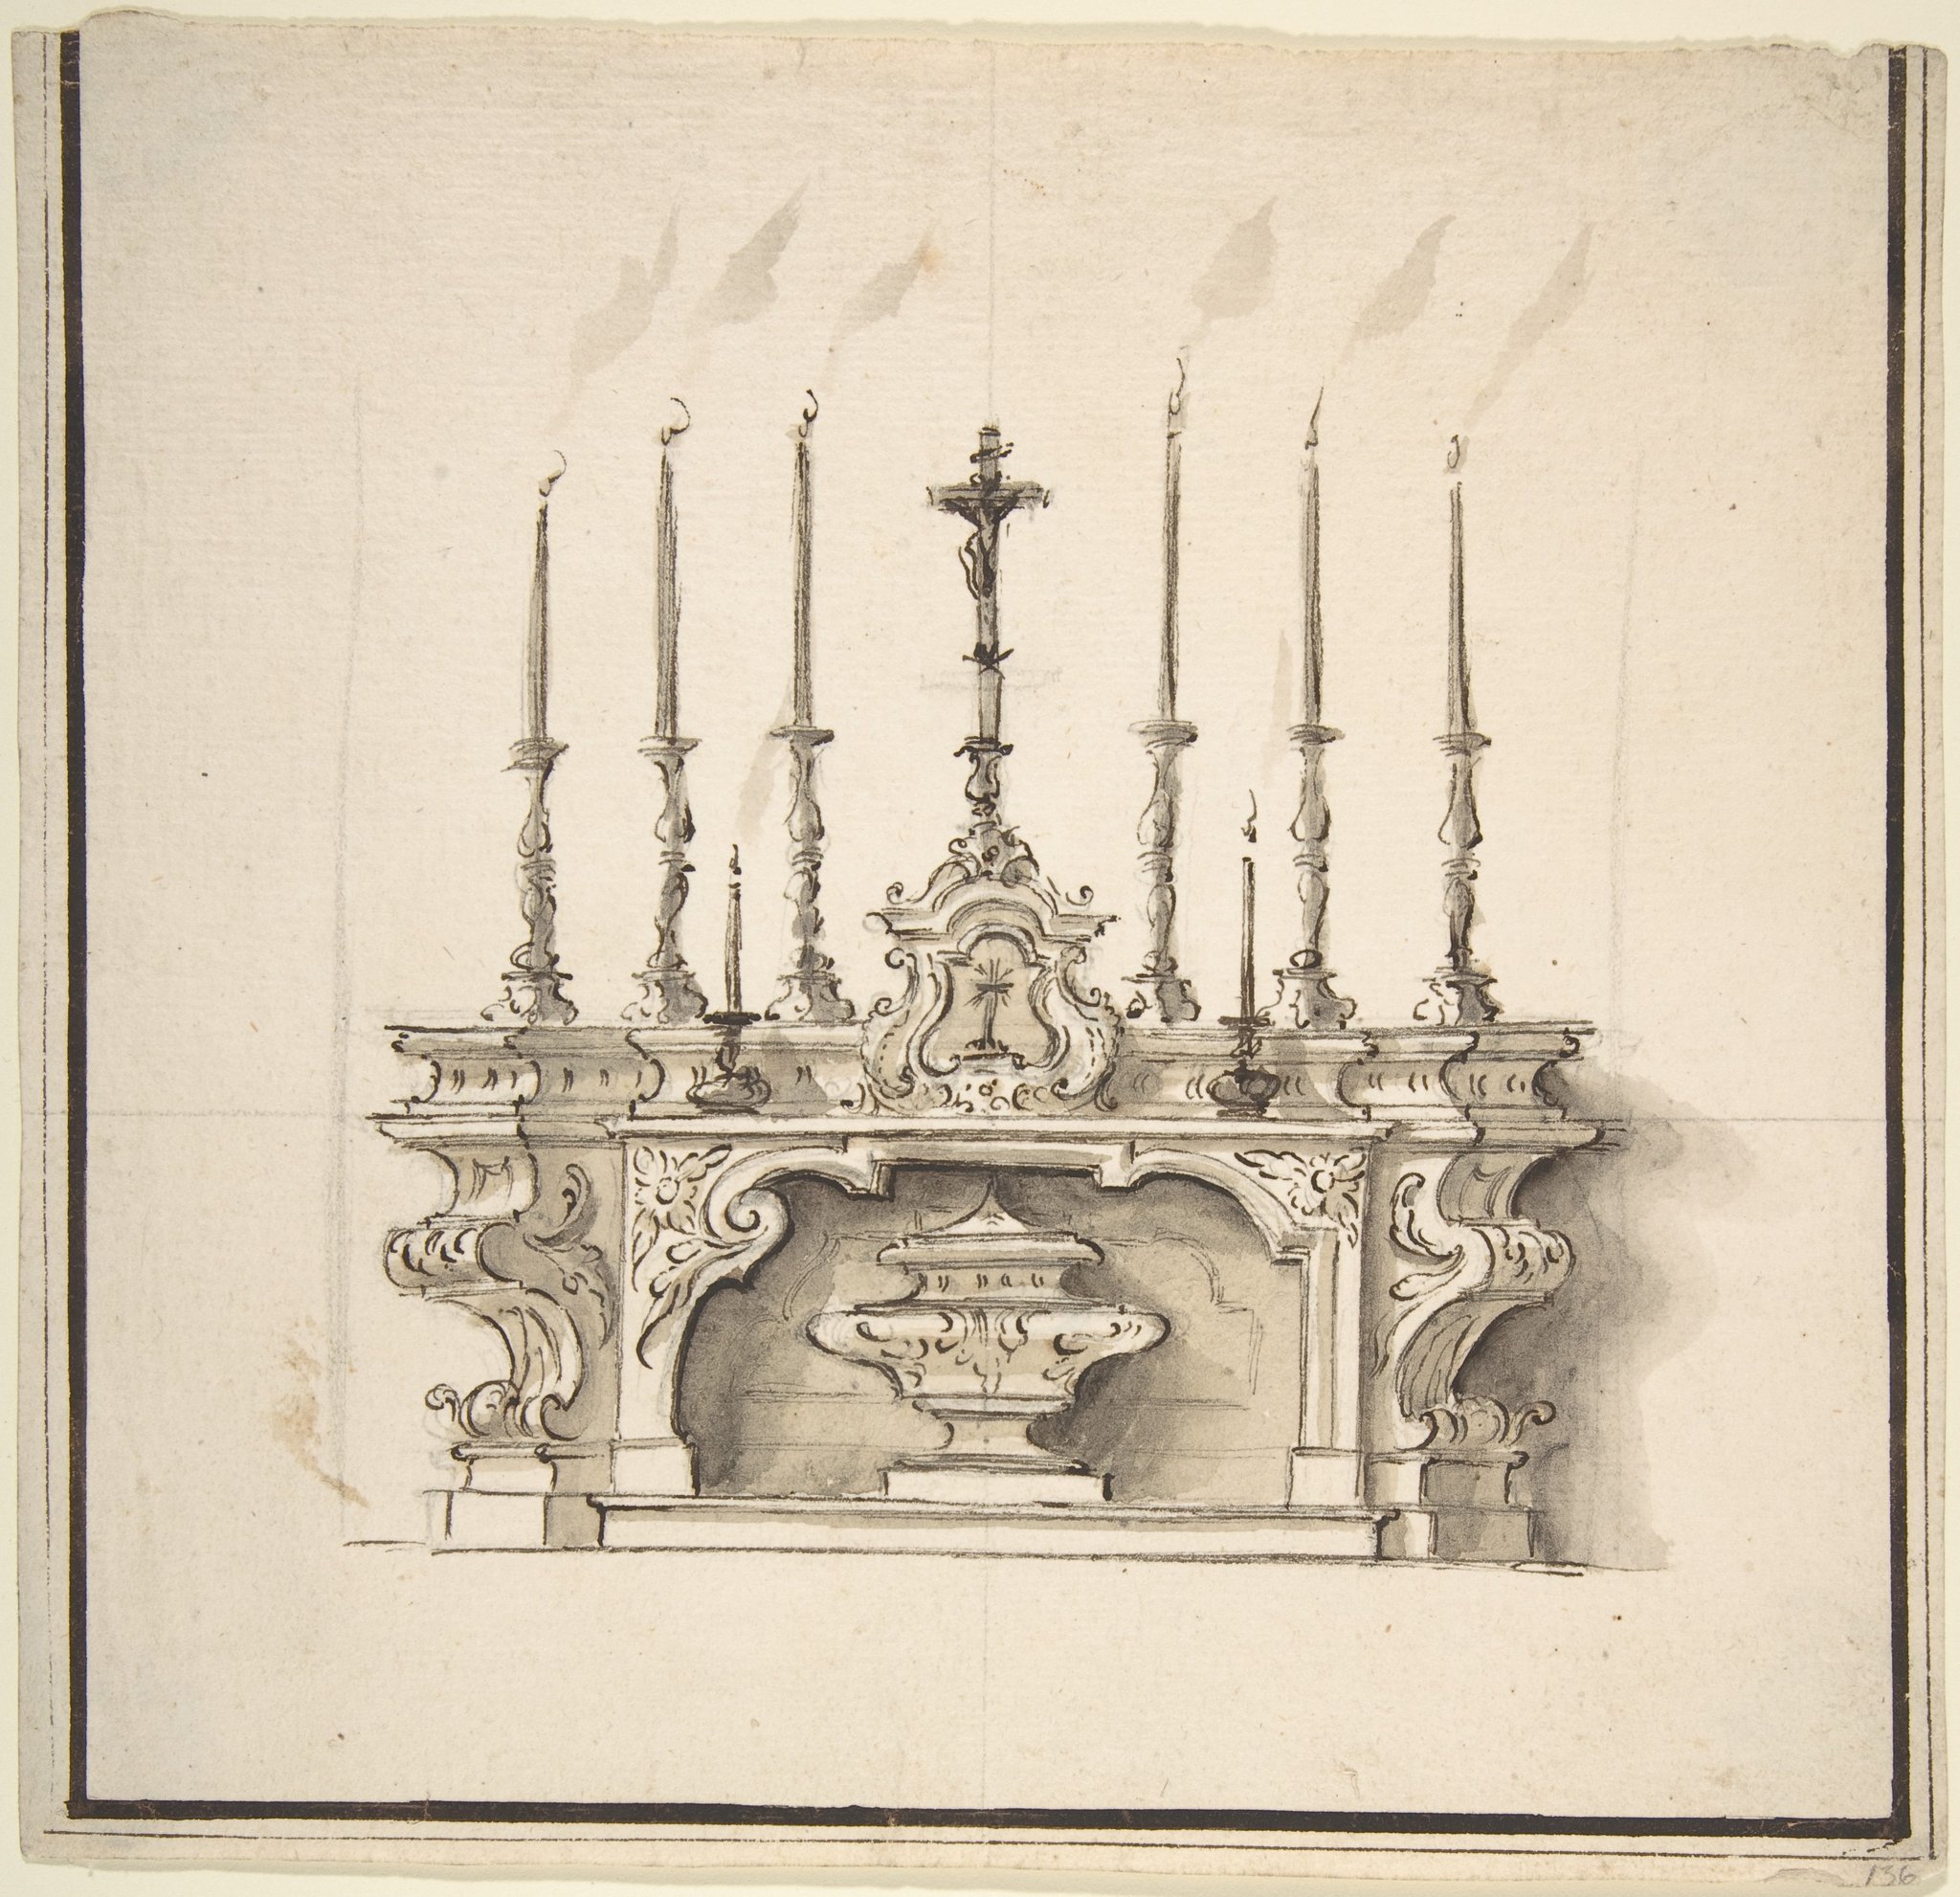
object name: drawing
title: Design for an Altar With Six Large Candelabra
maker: anonymous, italian, piedmontese, 18th century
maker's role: artist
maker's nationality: italian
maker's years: 1700-1800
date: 1700-1780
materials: graphite, ink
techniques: brush, pen, wash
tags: altars,candelabra